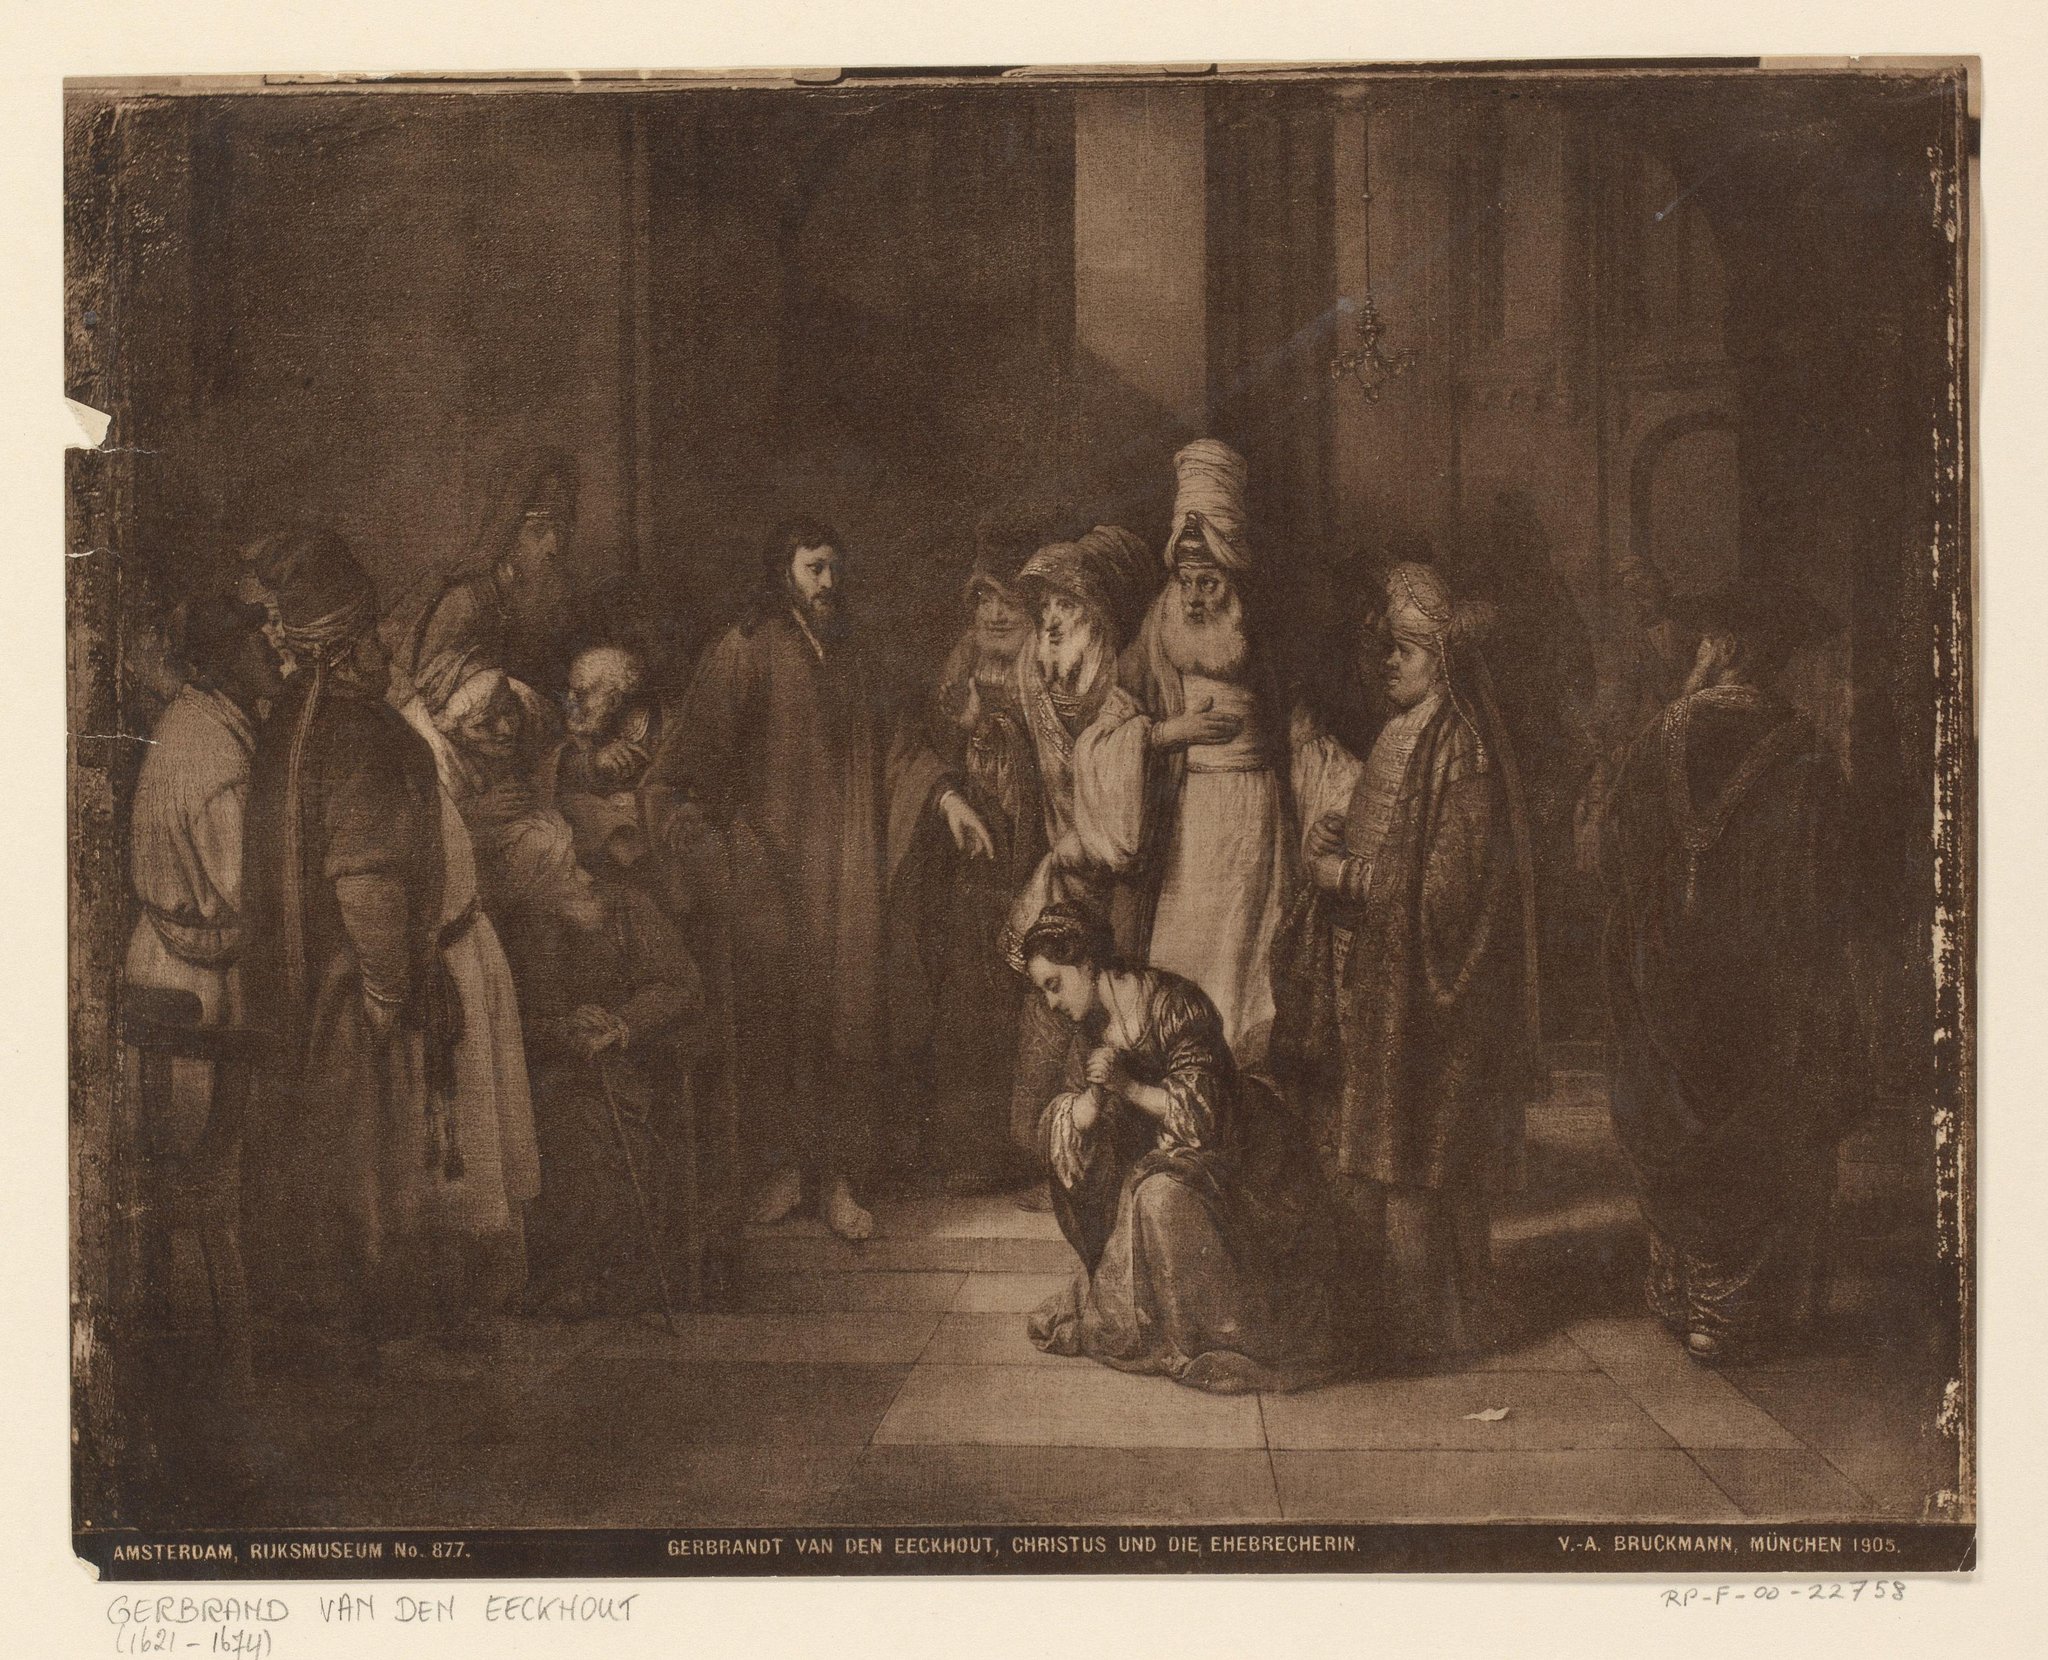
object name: reproduction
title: Gerbrandt van den Eeckhout, Christus und die Ehebrecherin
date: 1905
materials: paper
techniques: photograph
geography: munich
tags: pharisees bring a woman accused of adultery before christ (john 8:2-11)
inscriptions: inscription: ‘34/ Icon/ D’, inscription: ‘Amsterdam, Rijksmuseum No. 877.’